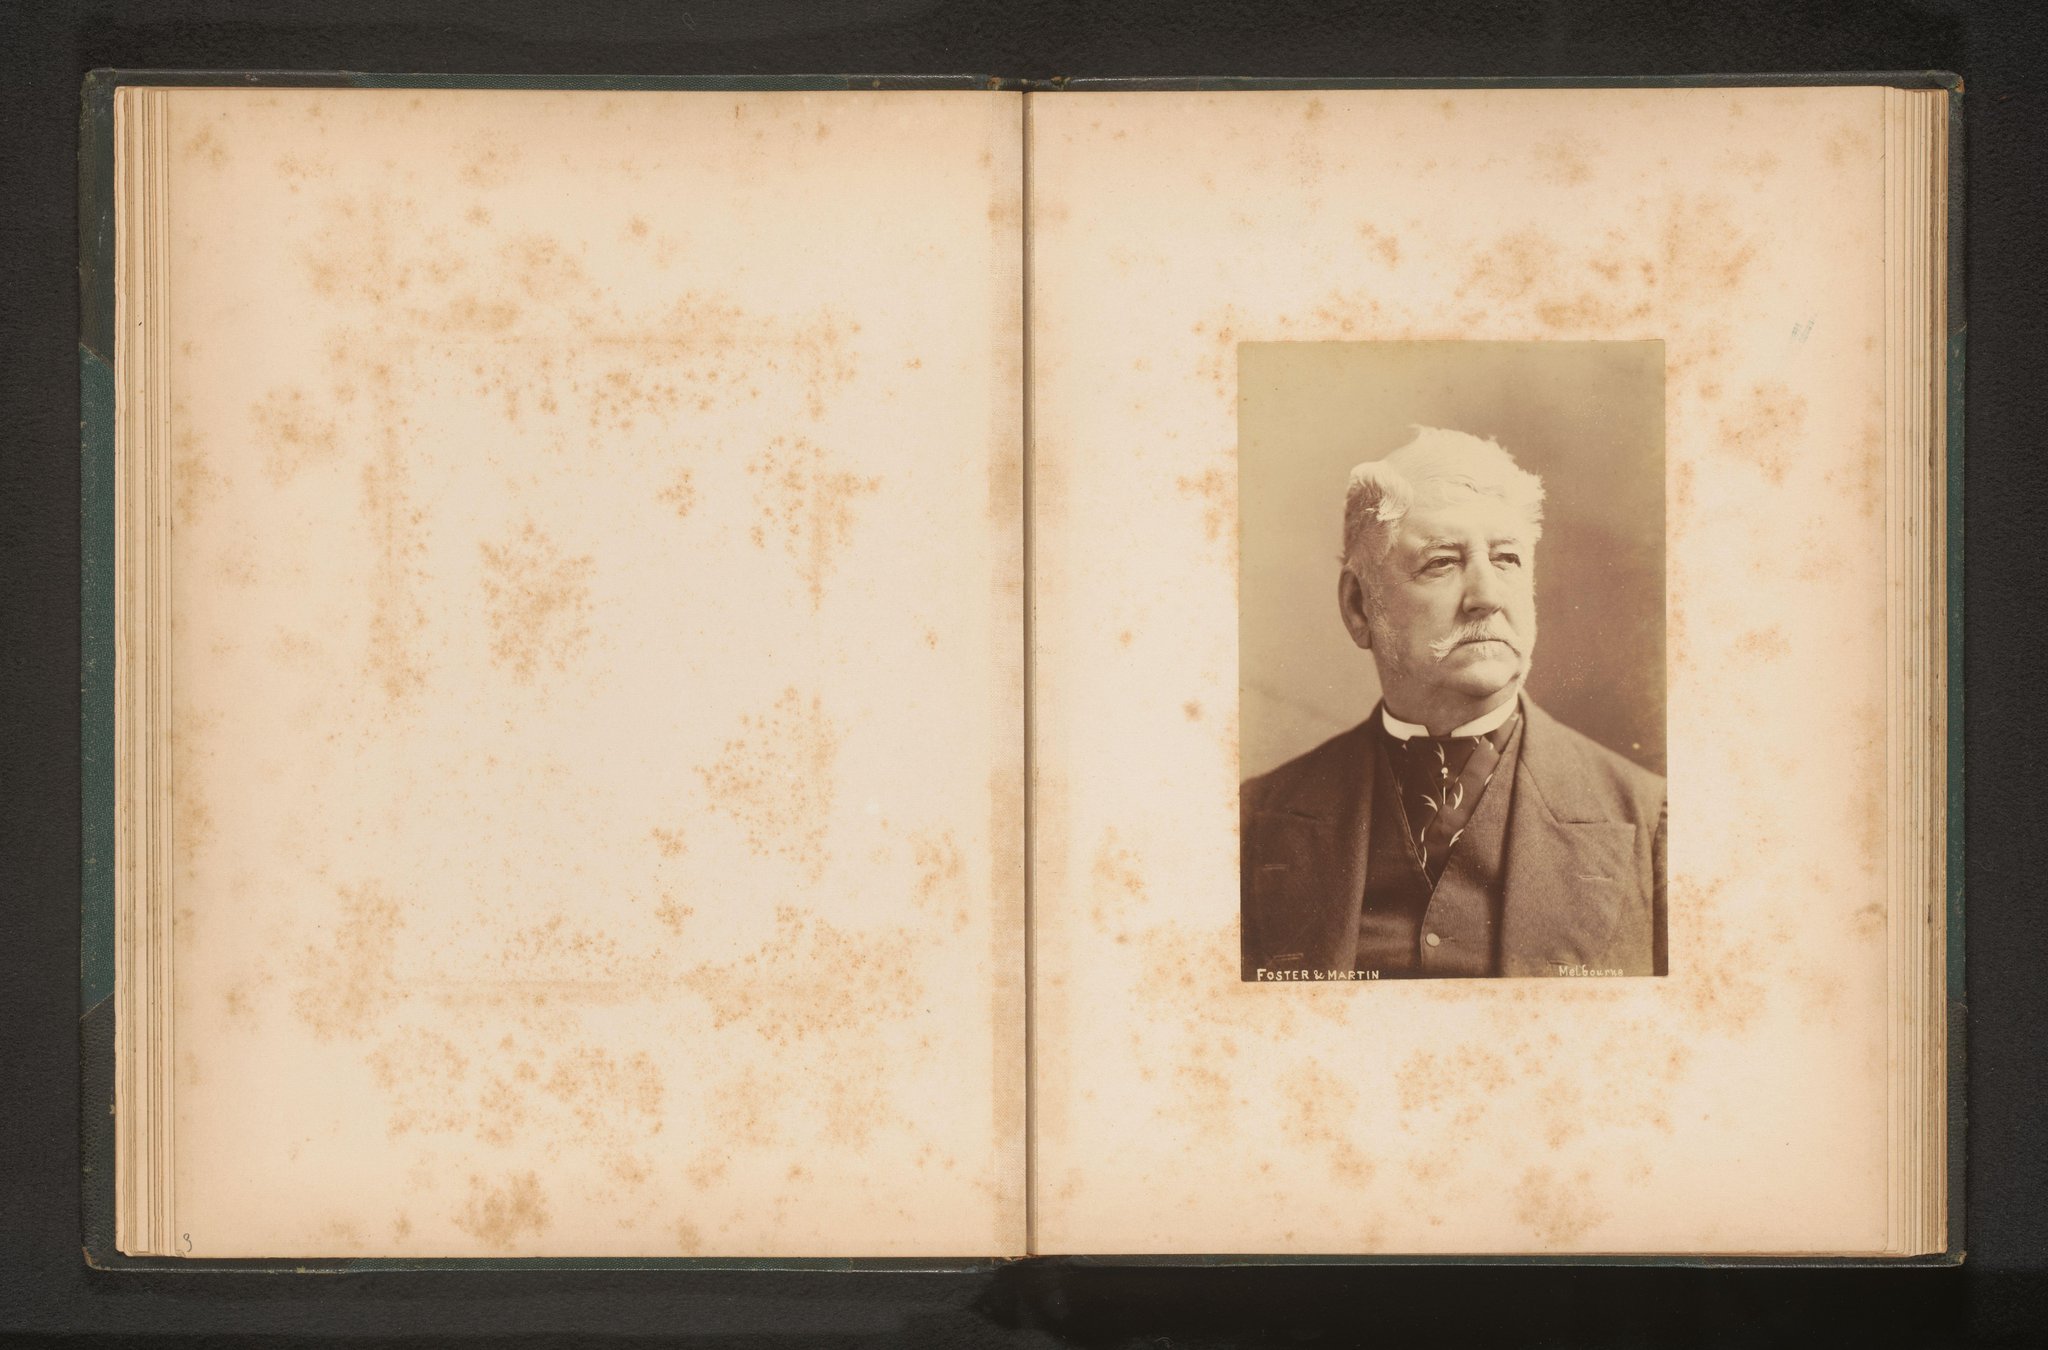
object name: page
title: Portret van Arthur Kennedy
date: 1880-1881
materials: photographic support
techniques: albumen print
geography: melbourne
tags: colonial governor